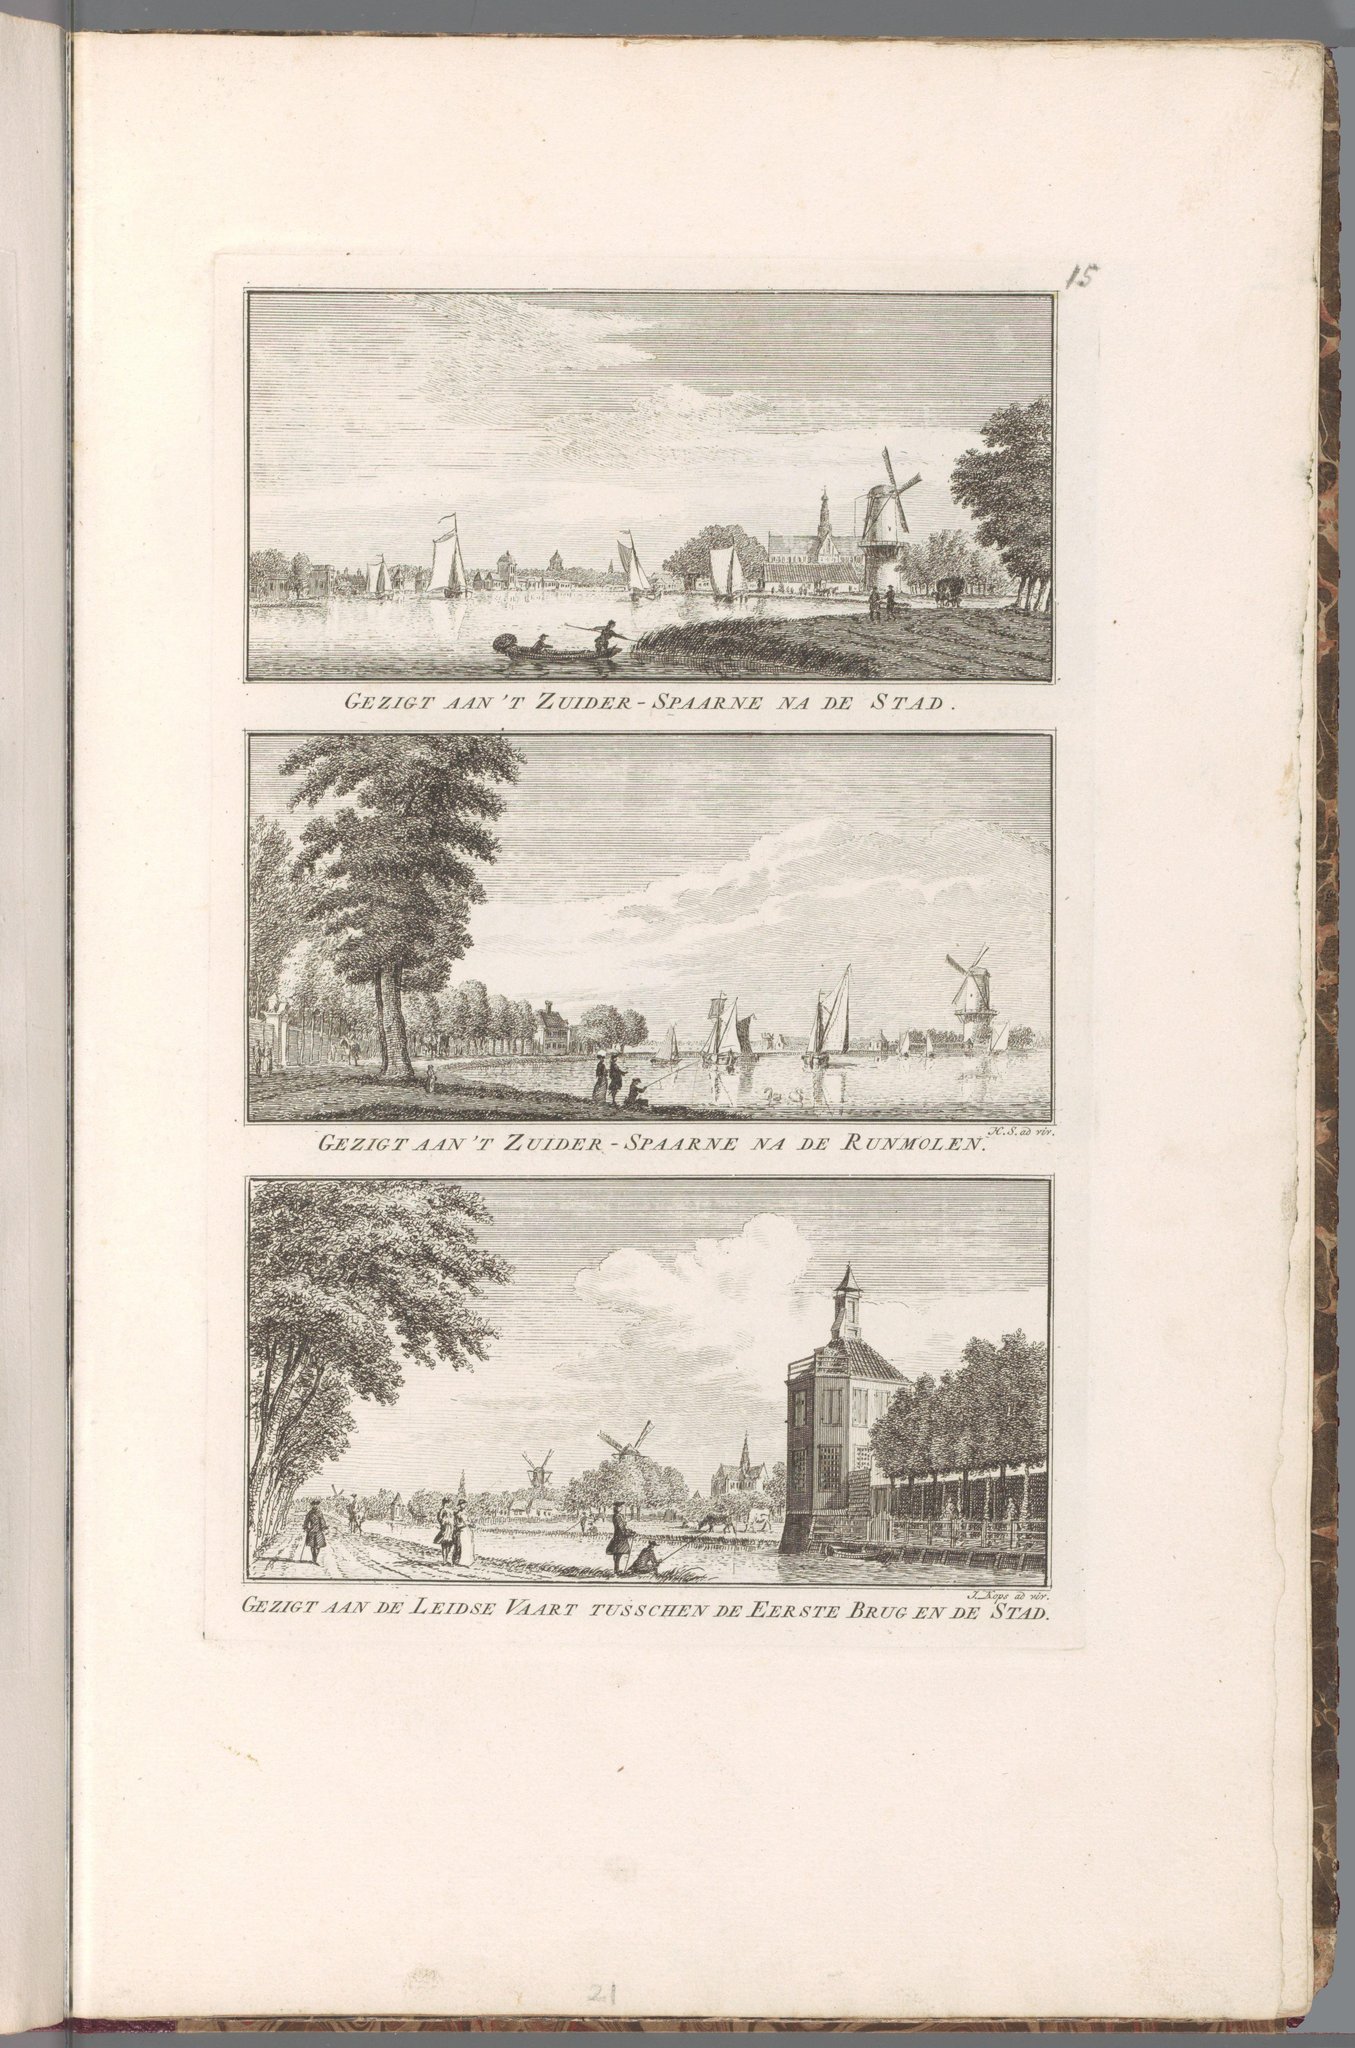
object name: album leaf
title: Gezigt aan 't Zuider-Spaarne na de Stad / Gezigt aan 't Zuider-Spaarne na de Runmolen / Gezigt aan de Leidse Vaart tusschen de Eerste Brug en de Stad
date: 1762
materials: paper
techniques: etching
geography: haarlem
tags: river, canal, lane, alley, haarlem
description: Drie voorstellingen. Boven: Gezicht op het Zuider Spaarne met op de achtergrond de stad Haarlem. Midden: Gezicht op het Zuider Spaarne en de Runmolen bij Haarlem. Onder: Gezicht op de Leidsevaart. Op de achtergrond de stad Haarlem. Deze prent maakt deel uit van een album.